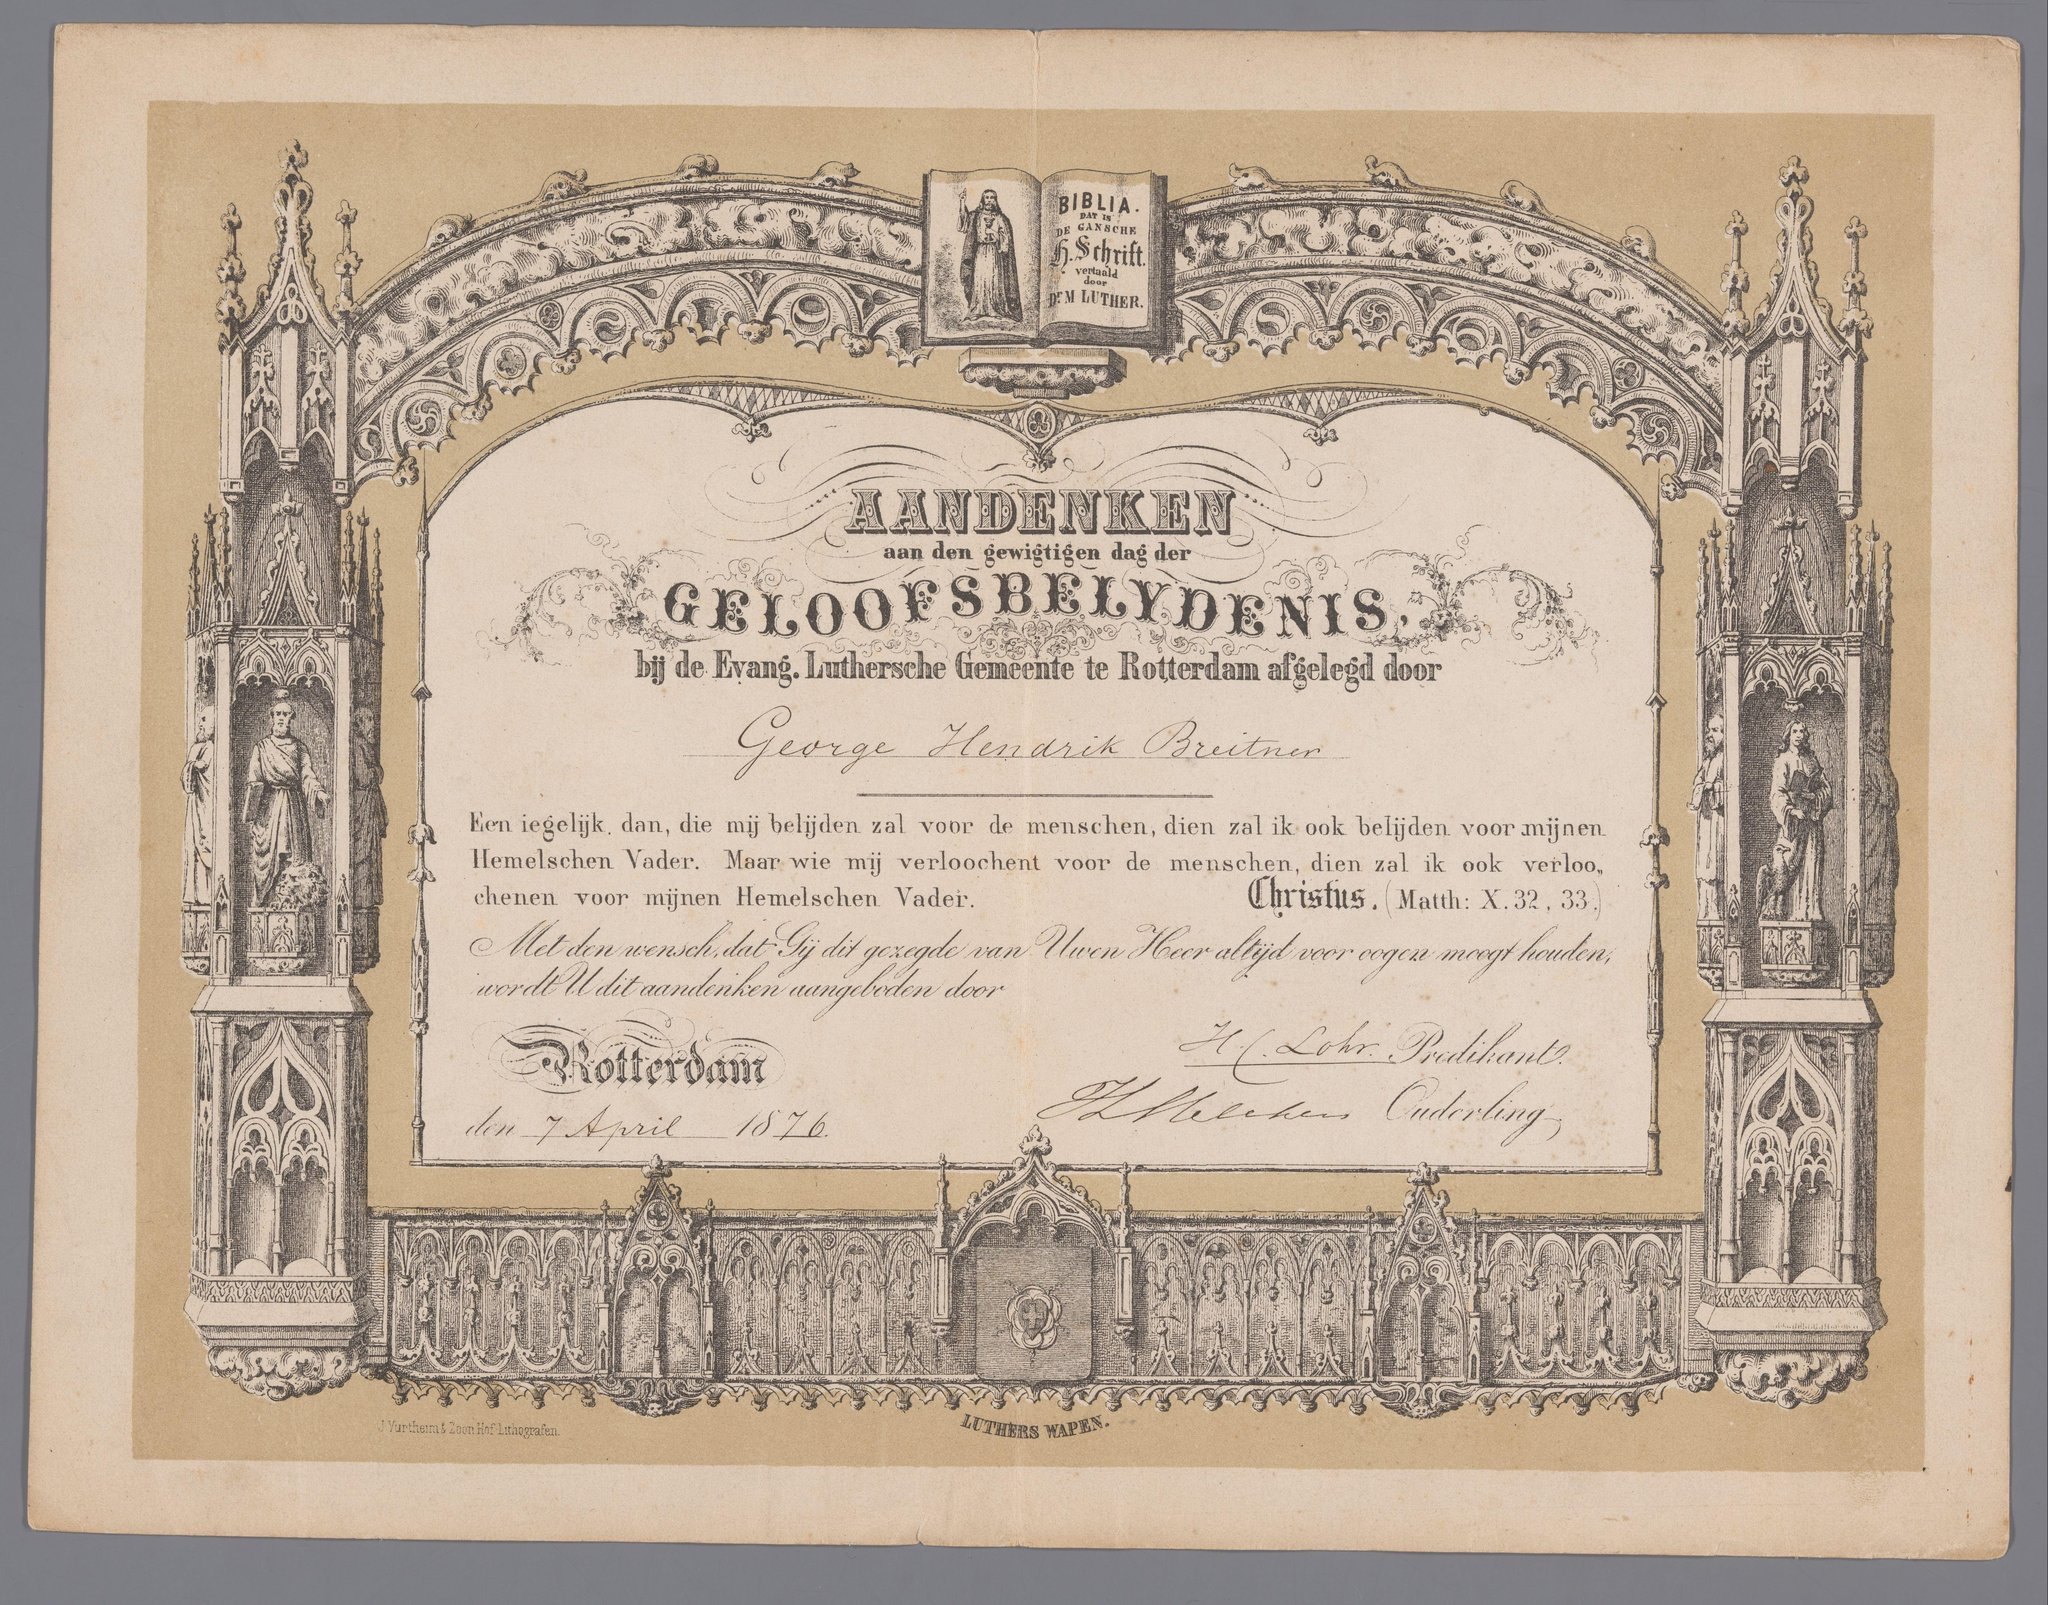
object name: document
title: Akte van de geloofsbelijdenis van George Hendrik Breitner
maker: Anonymous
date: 1876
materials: paper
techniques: printing, writing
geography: netherlands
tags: amsterdam, painter, print maker, draughtsman, george hendrik breitner